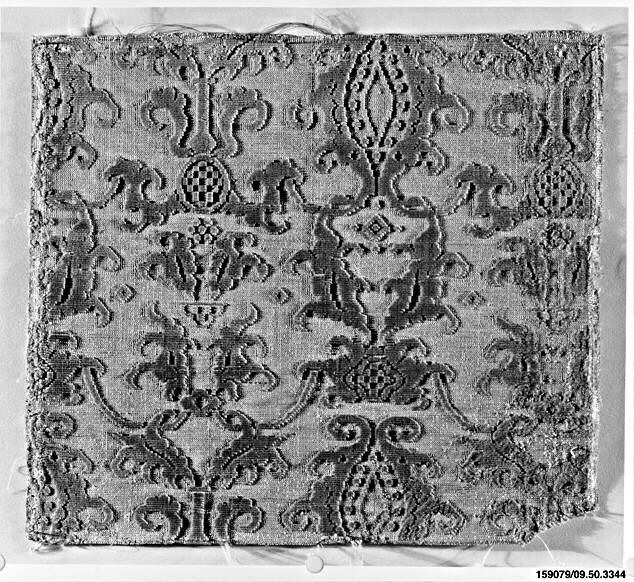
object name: piece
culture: chinese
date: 1801-1900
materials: silk